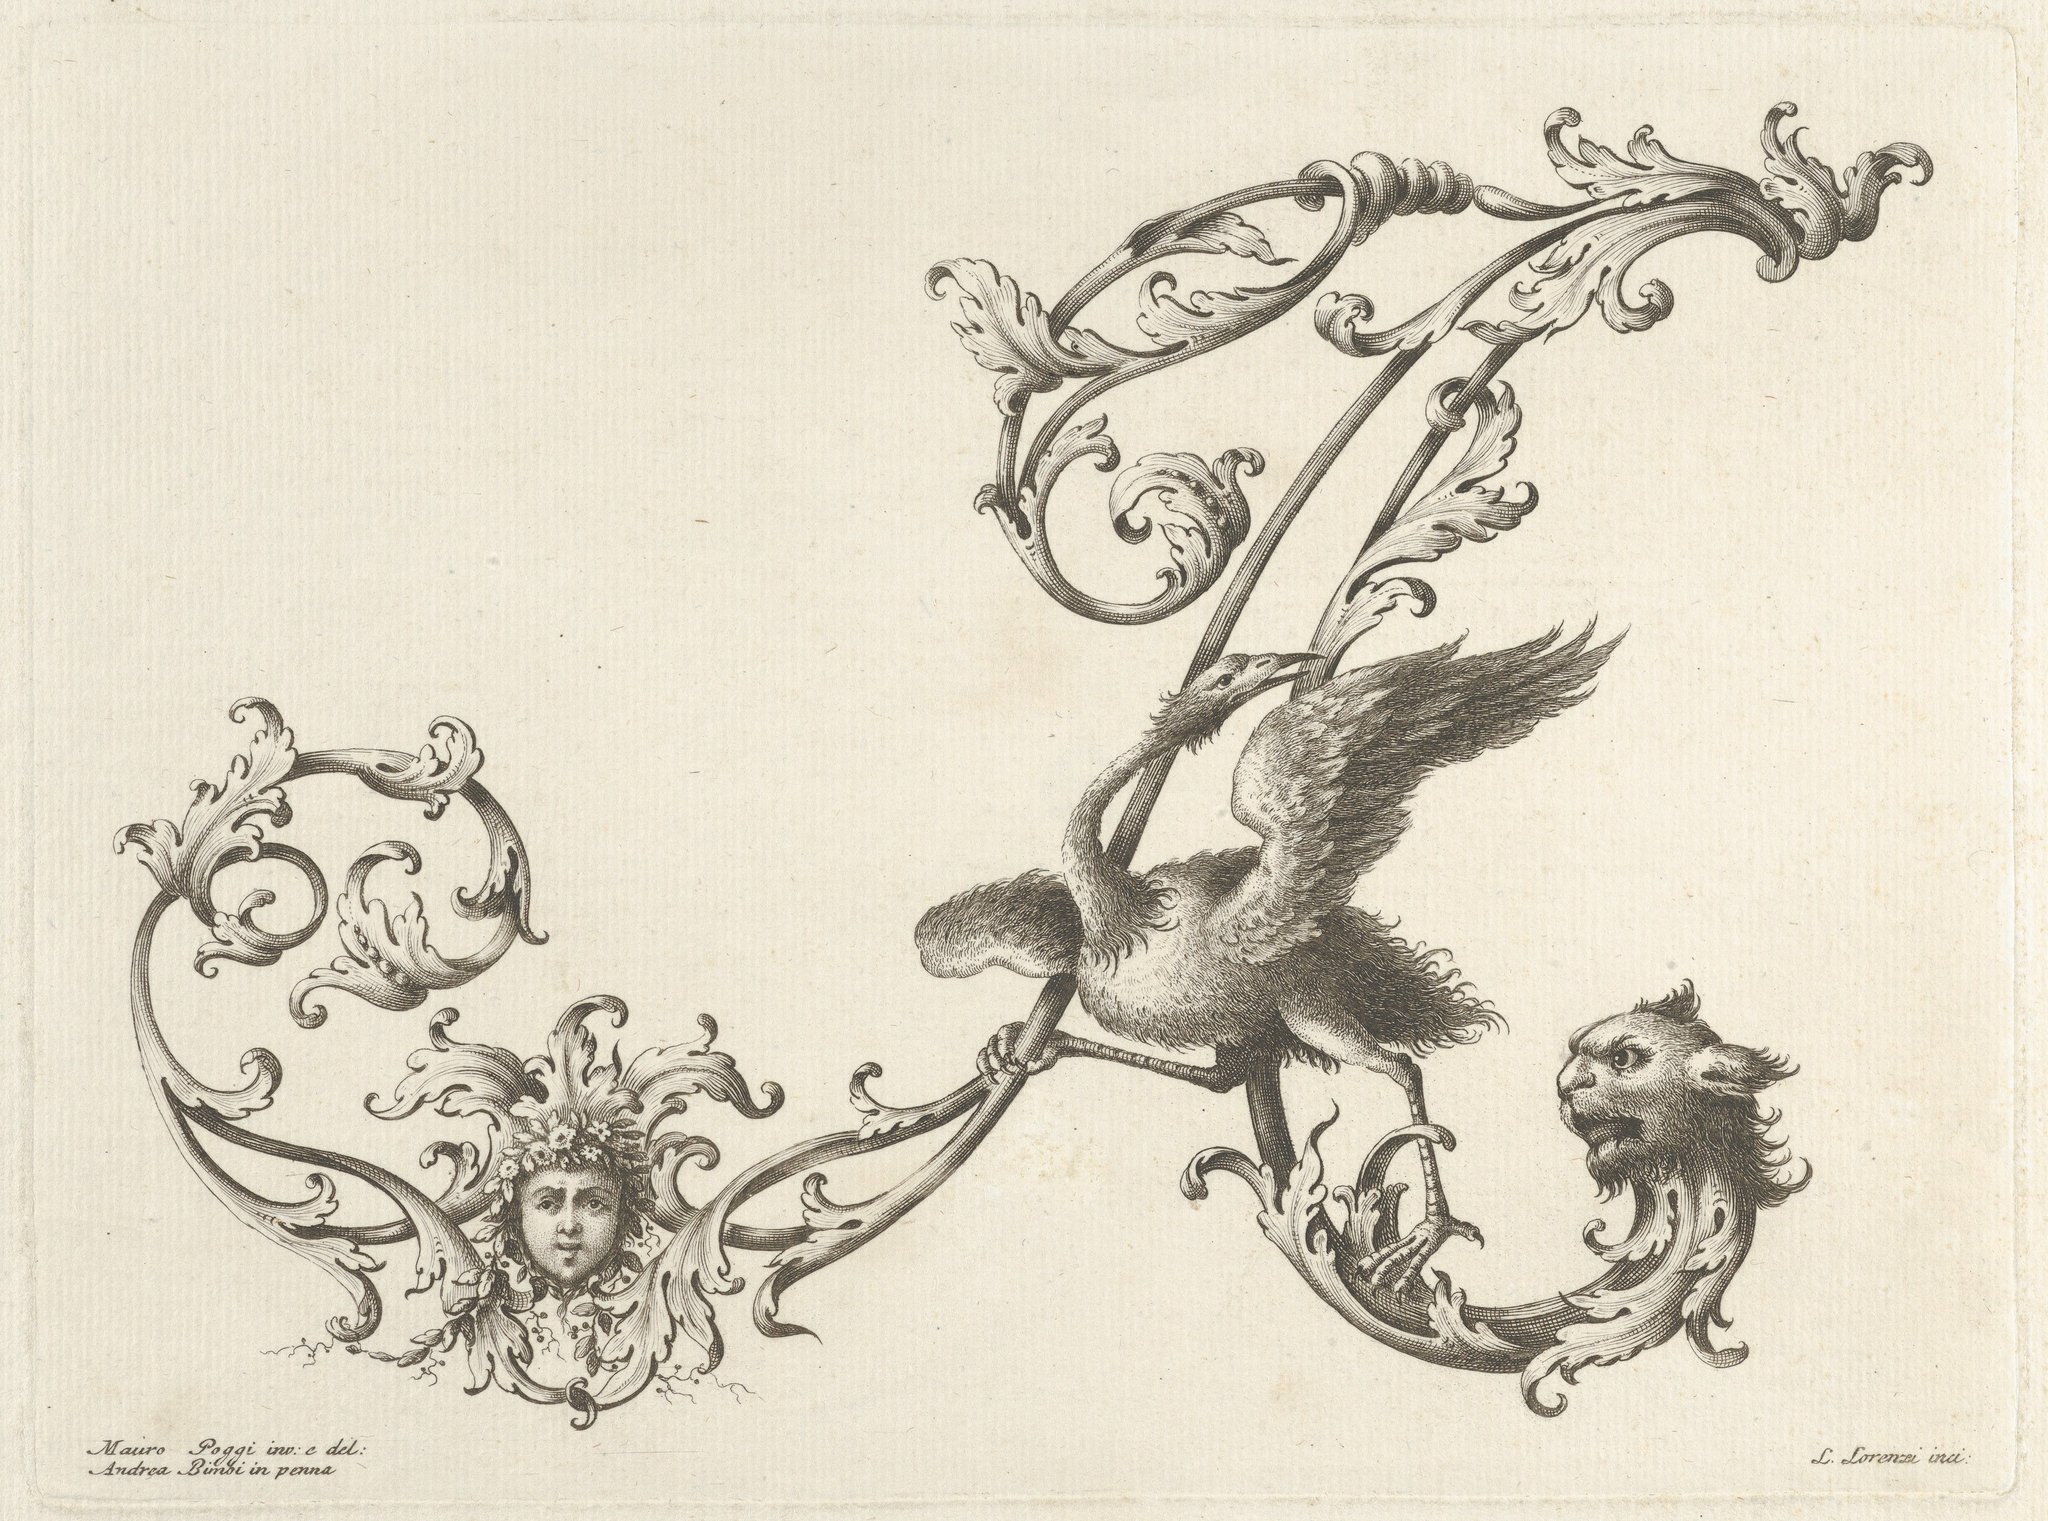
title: Alfabeto Di Lettere Iniziale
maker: mauro poggi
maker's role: designer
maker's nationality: italian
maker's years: 1700-1800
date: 1760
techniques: engraving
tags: birds,faces